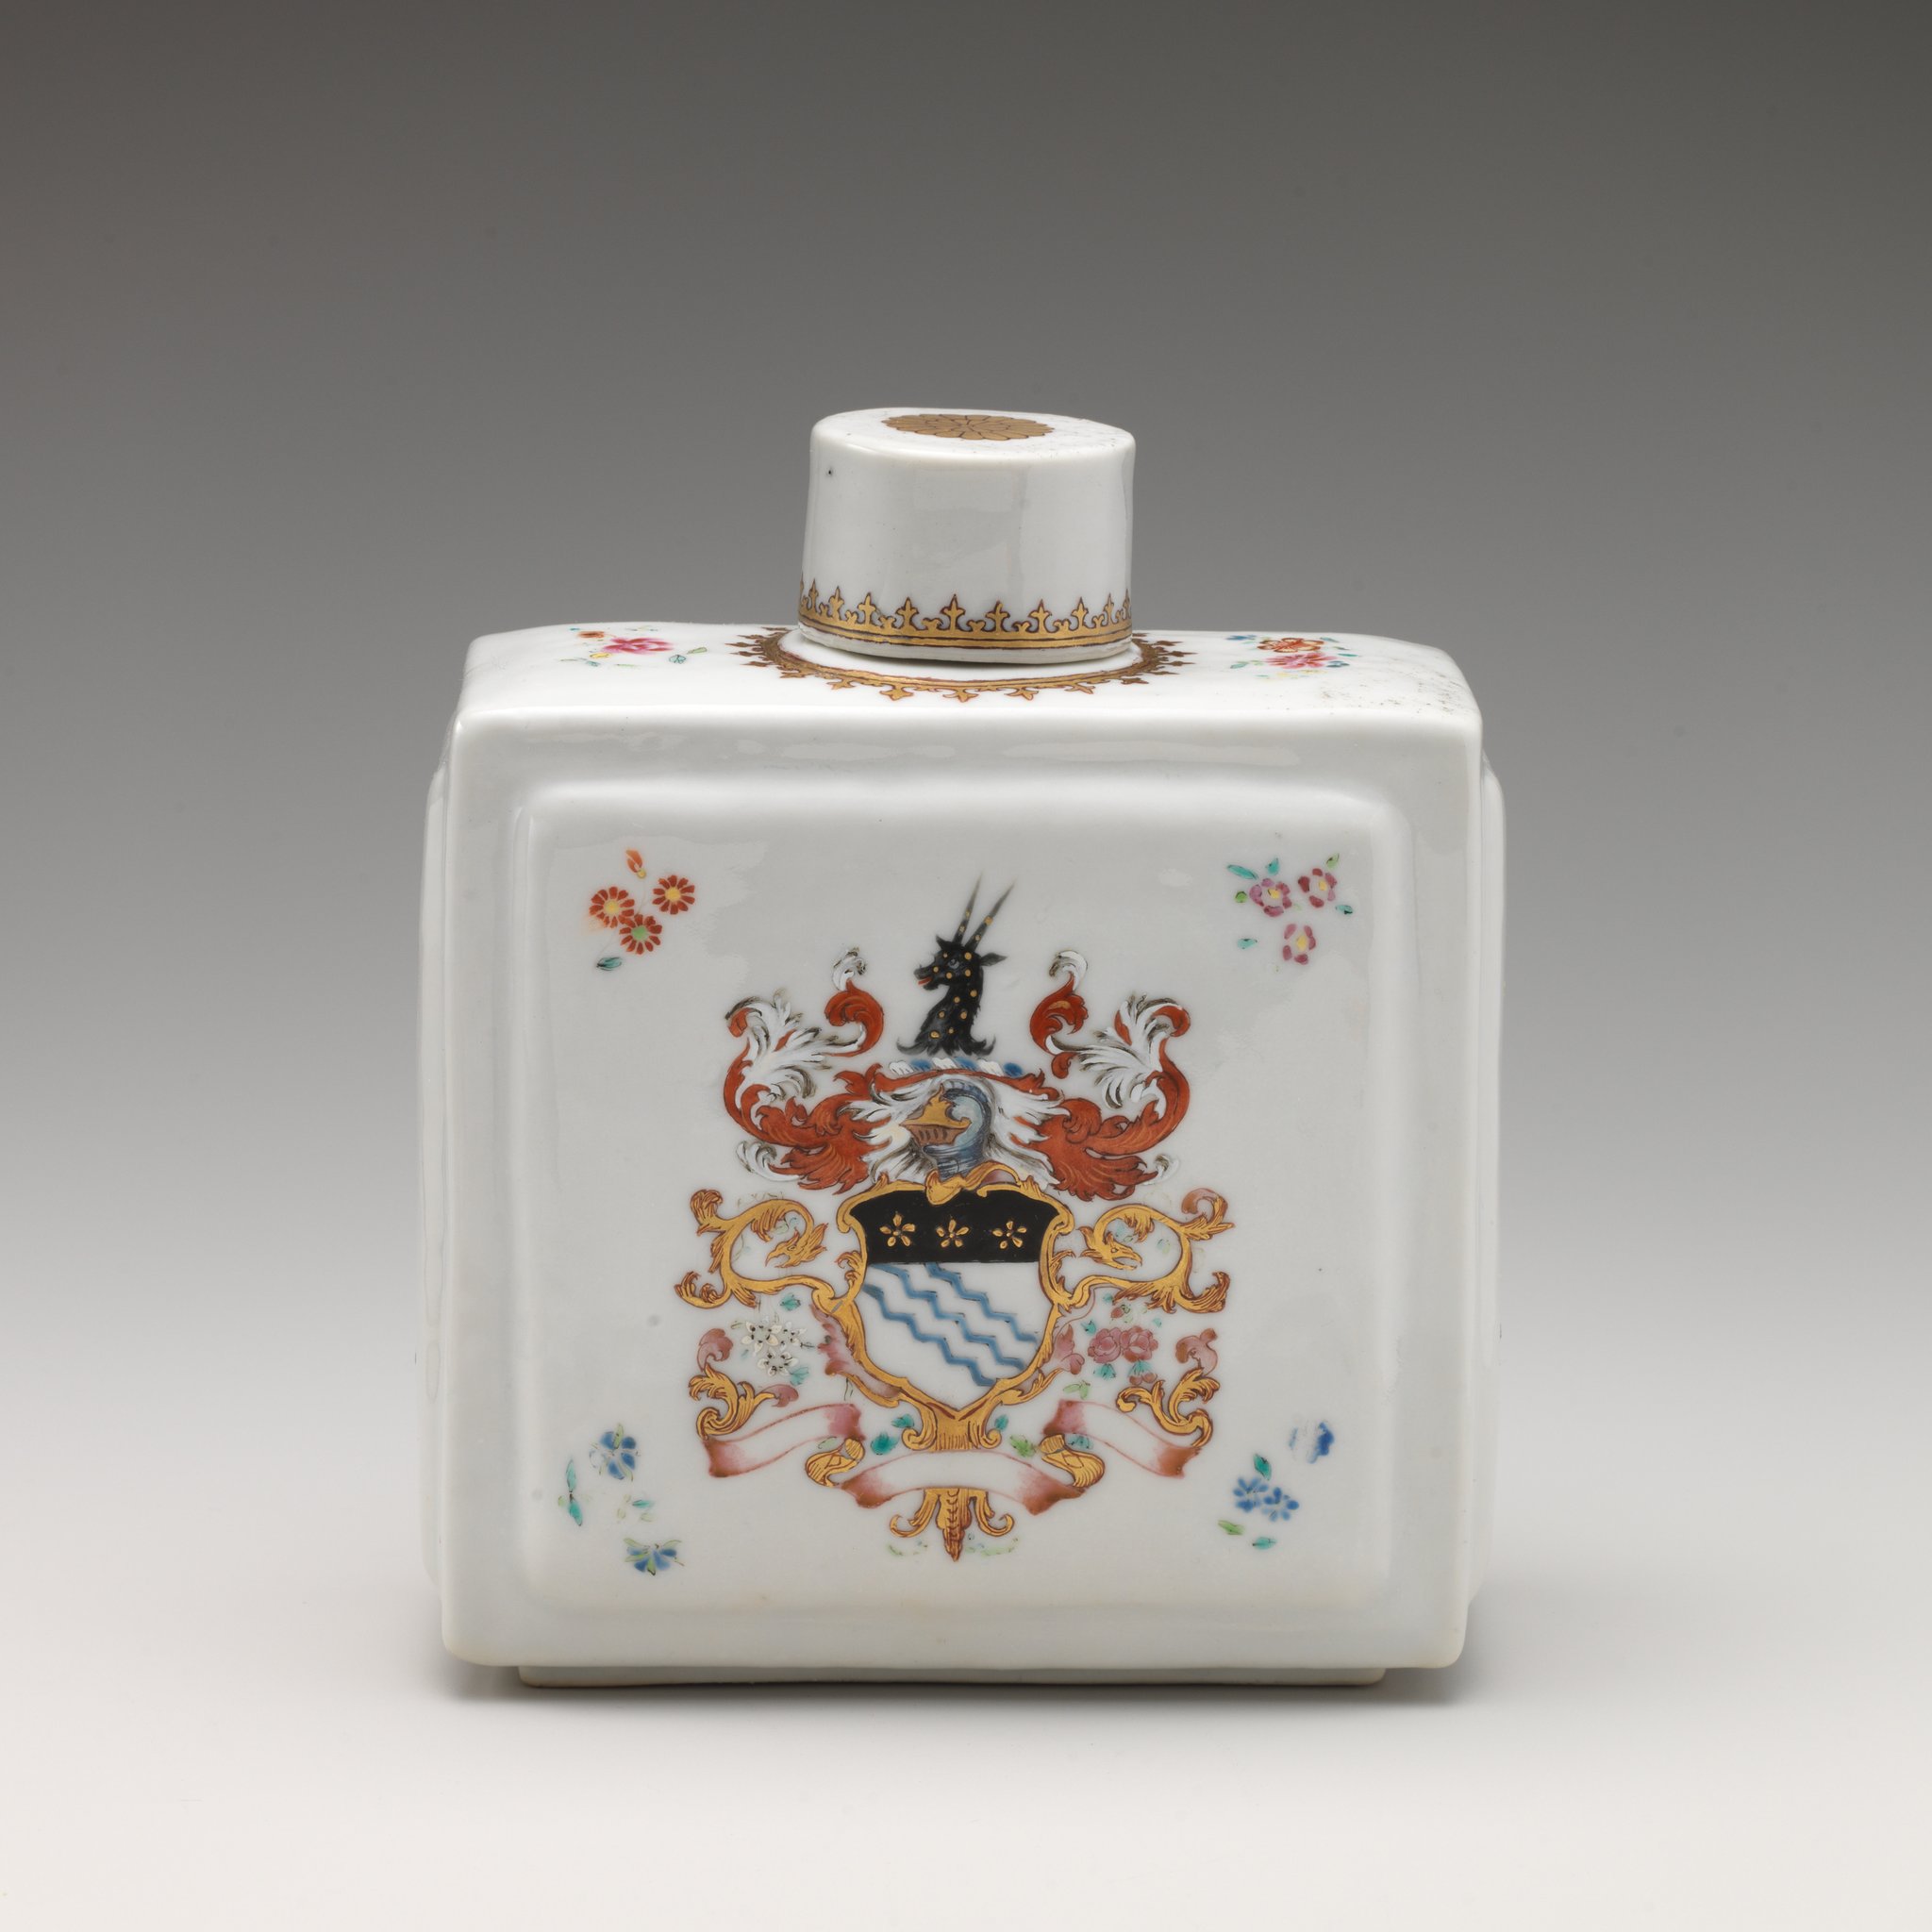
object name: tea caddy with cover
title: Tea caddy with cover with armorial decoration (part of a service)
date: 1750-1760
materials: enamel, hard paste porcelain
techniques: gilding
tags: coat of arms